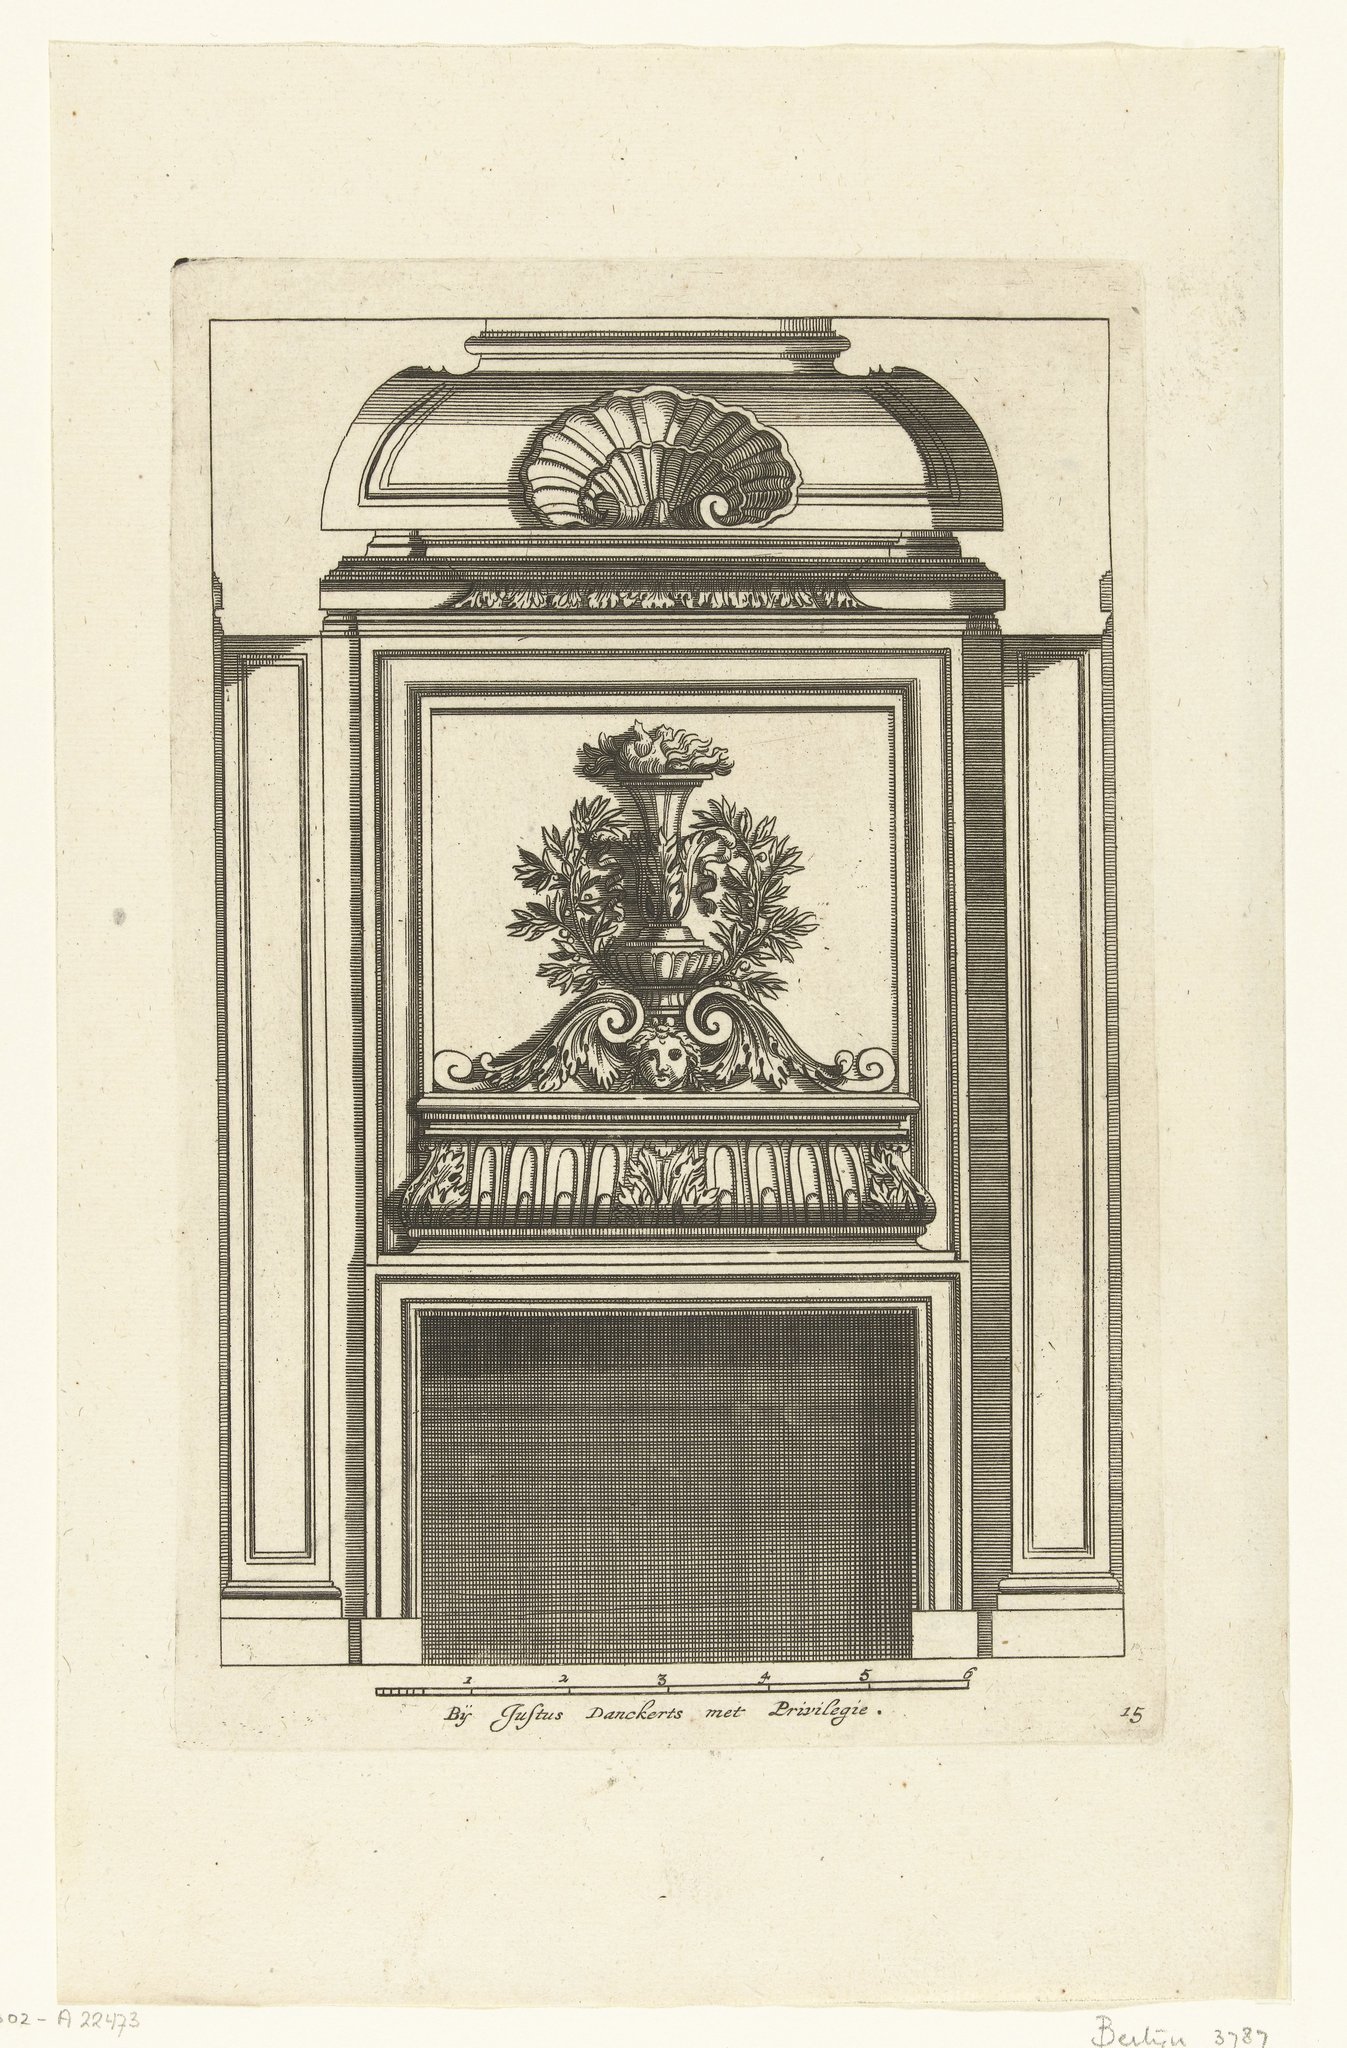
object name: print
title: Onderboezems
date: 1675-1686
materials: paper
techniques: etching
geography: netherlands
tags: chimney-piece, mantelpiece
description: Het fries boven het tablet van de schoorsteenboezem is gedecoreerd met een eierlijst en bladeren, daarboven bevindt zich een brandende urn omringd door lauriertakken.